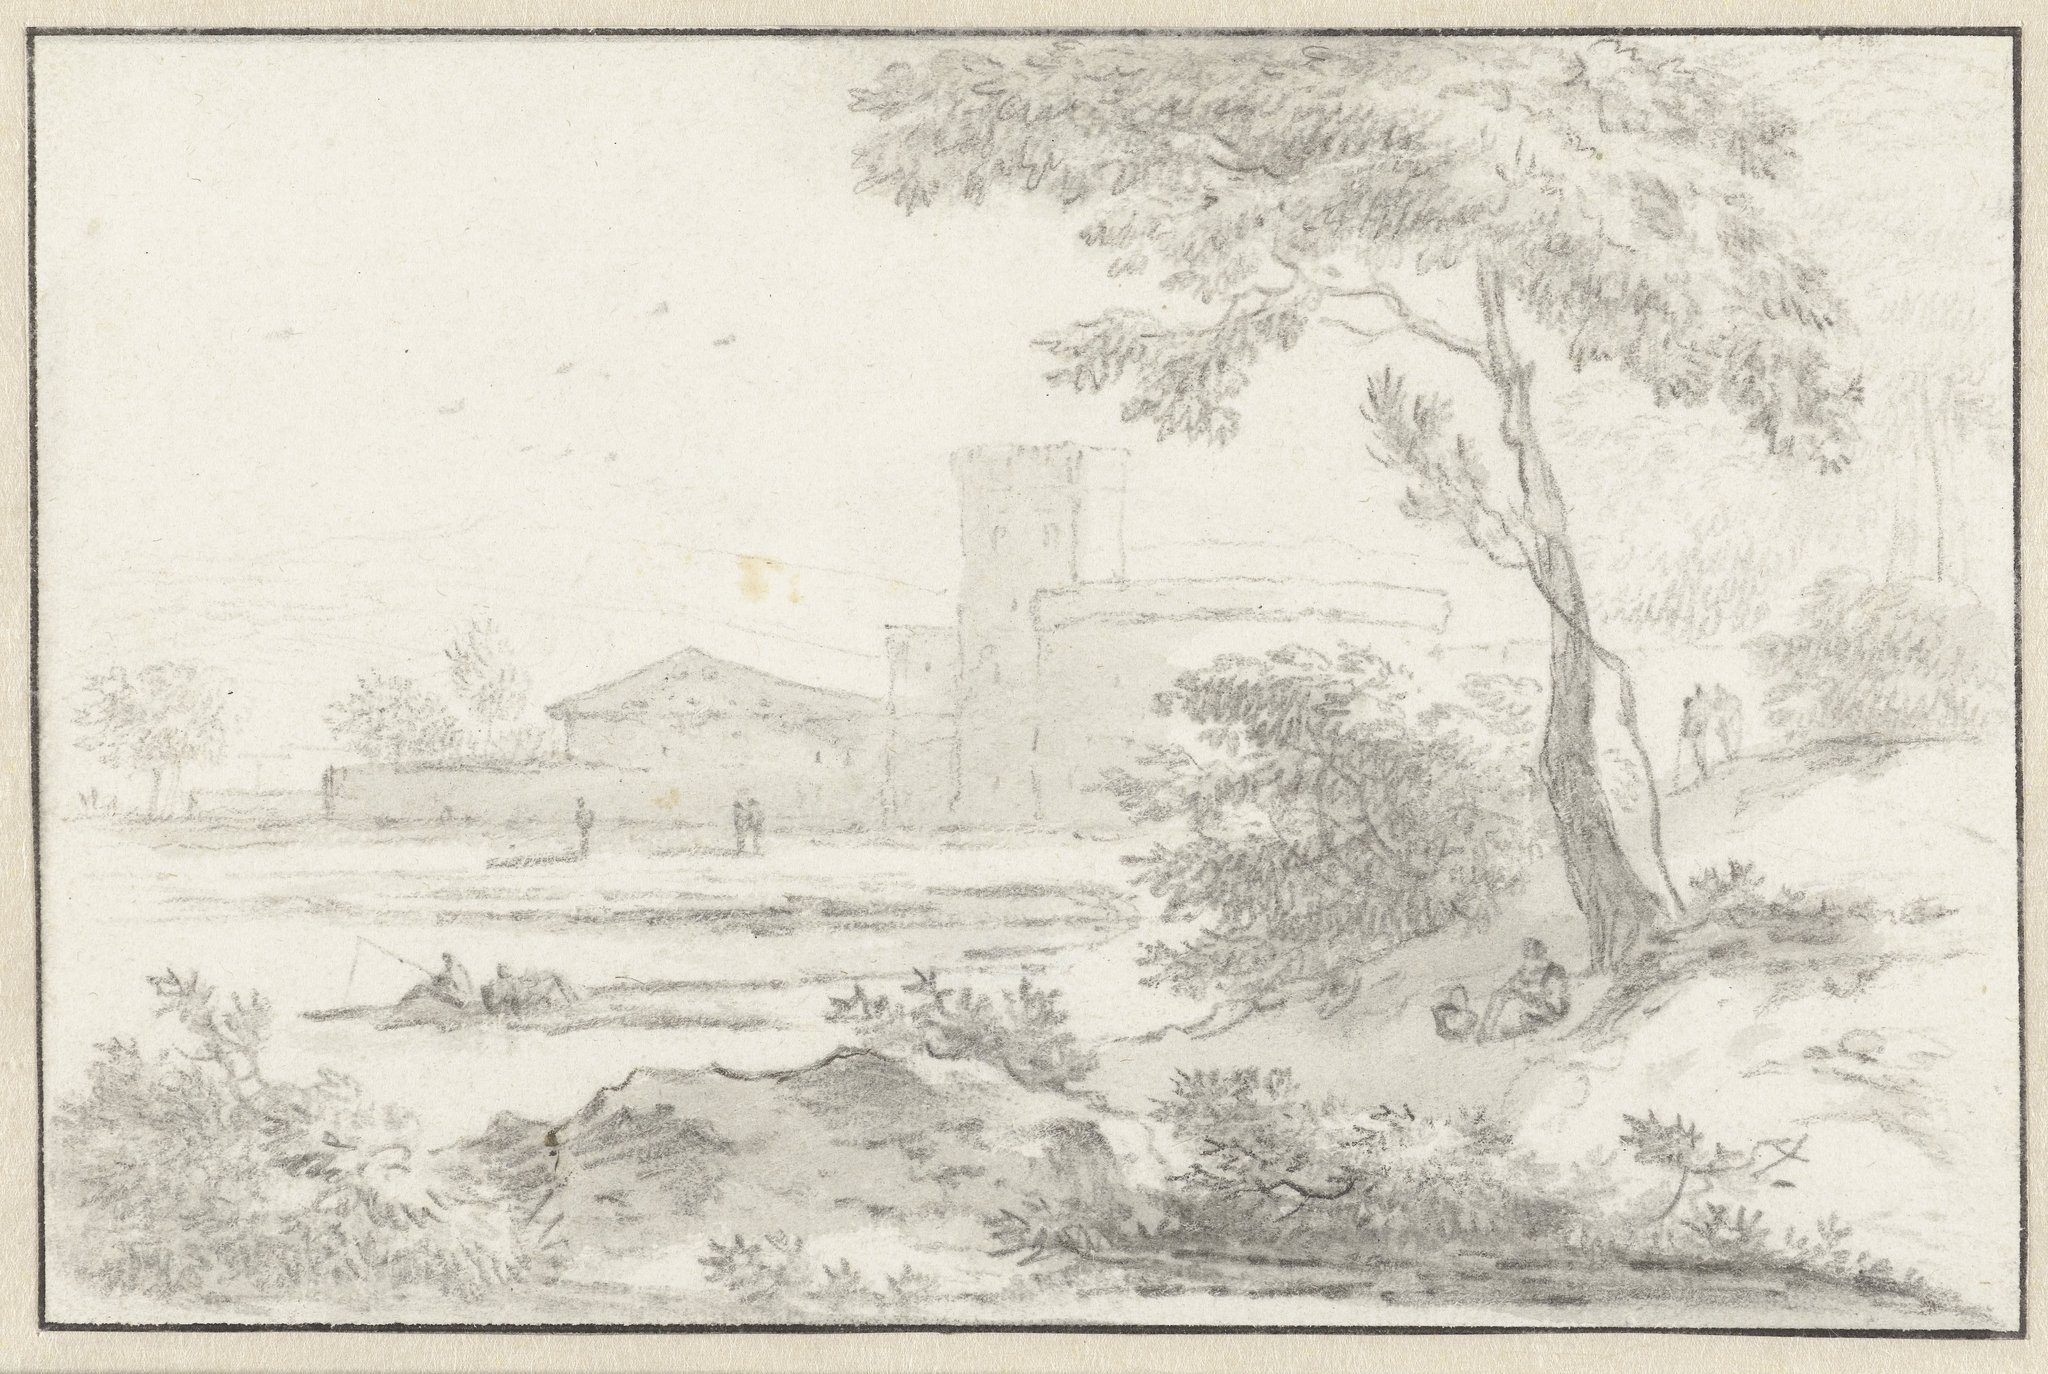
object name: drawing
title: Italianate Landscape with Fortified Building in the Background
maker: hendrik van der straaten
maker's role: draughtsman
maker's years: 1665-1722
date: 1685-1689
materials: chalk, ink, paper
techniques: brush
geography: haarlem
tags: farm or solitary house in landscape